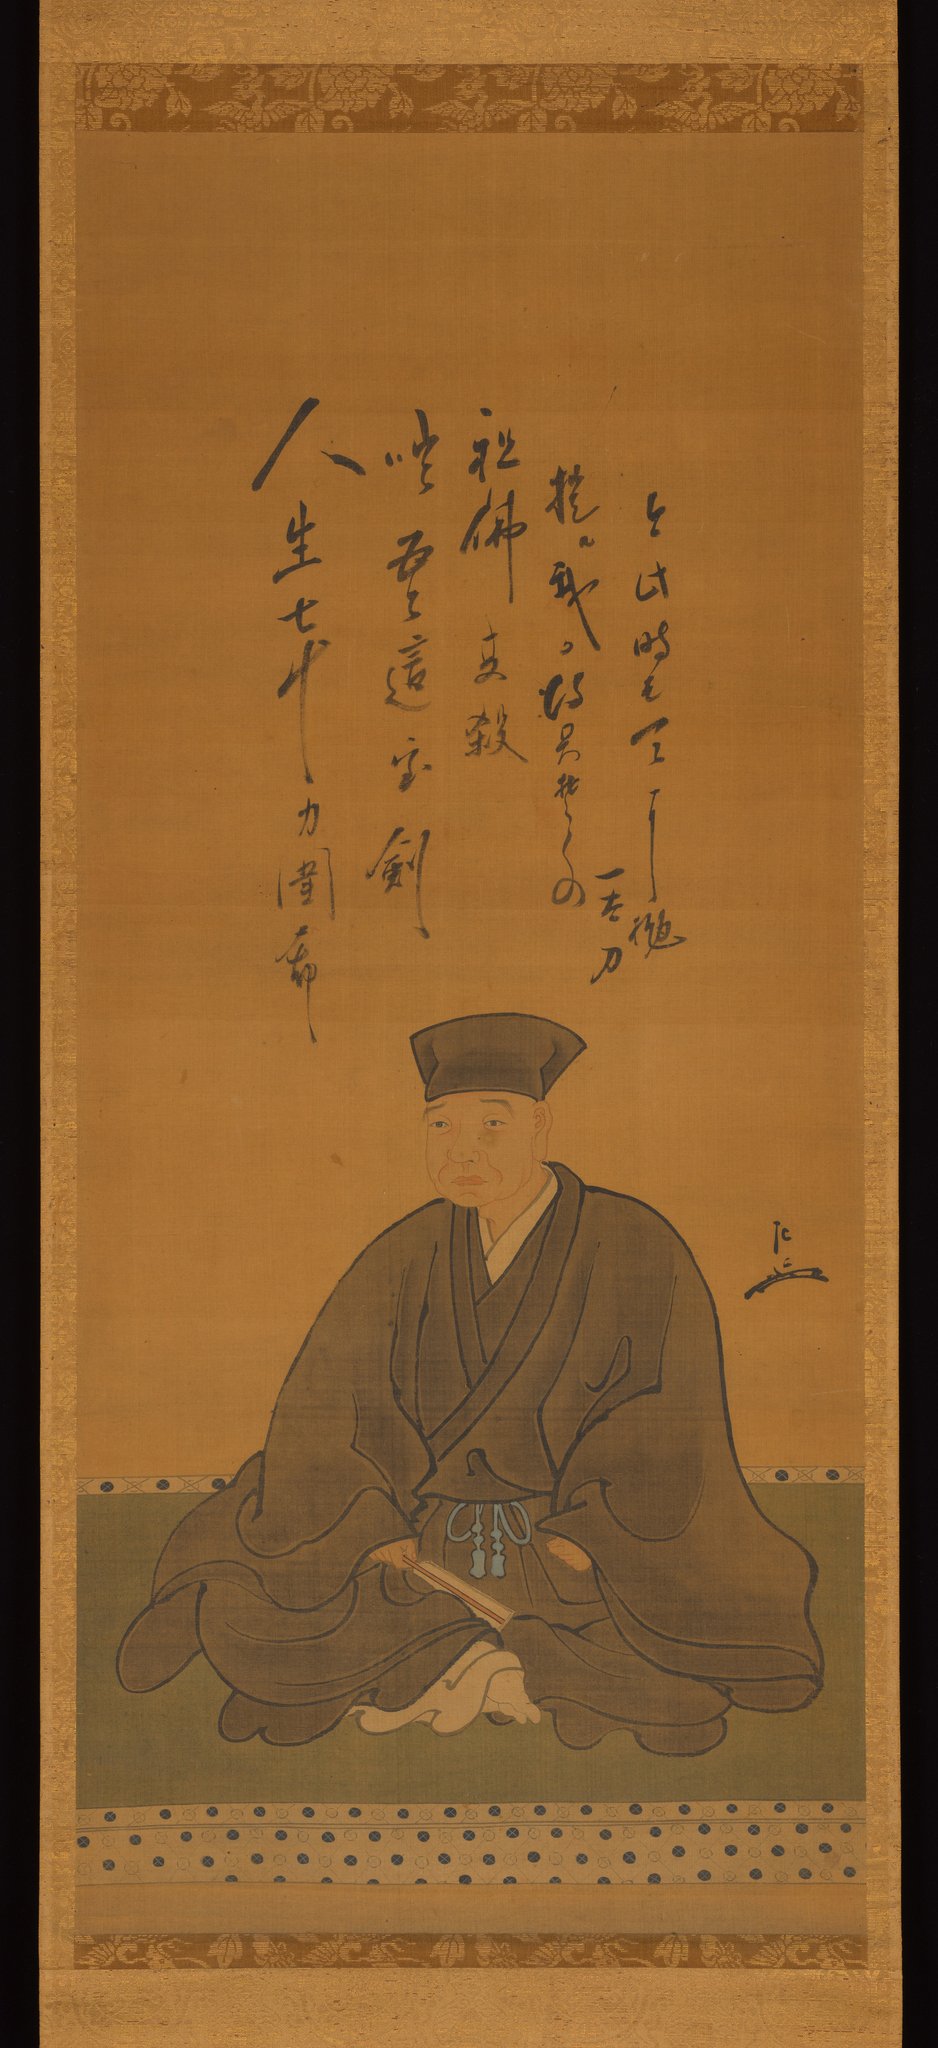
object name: hanging scroll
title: Portrait of Sen no Rikyū with his Death Poem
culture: japanese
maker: unidentified artist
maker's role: artist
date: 1601-1633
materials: ink, silk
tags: men,portraits